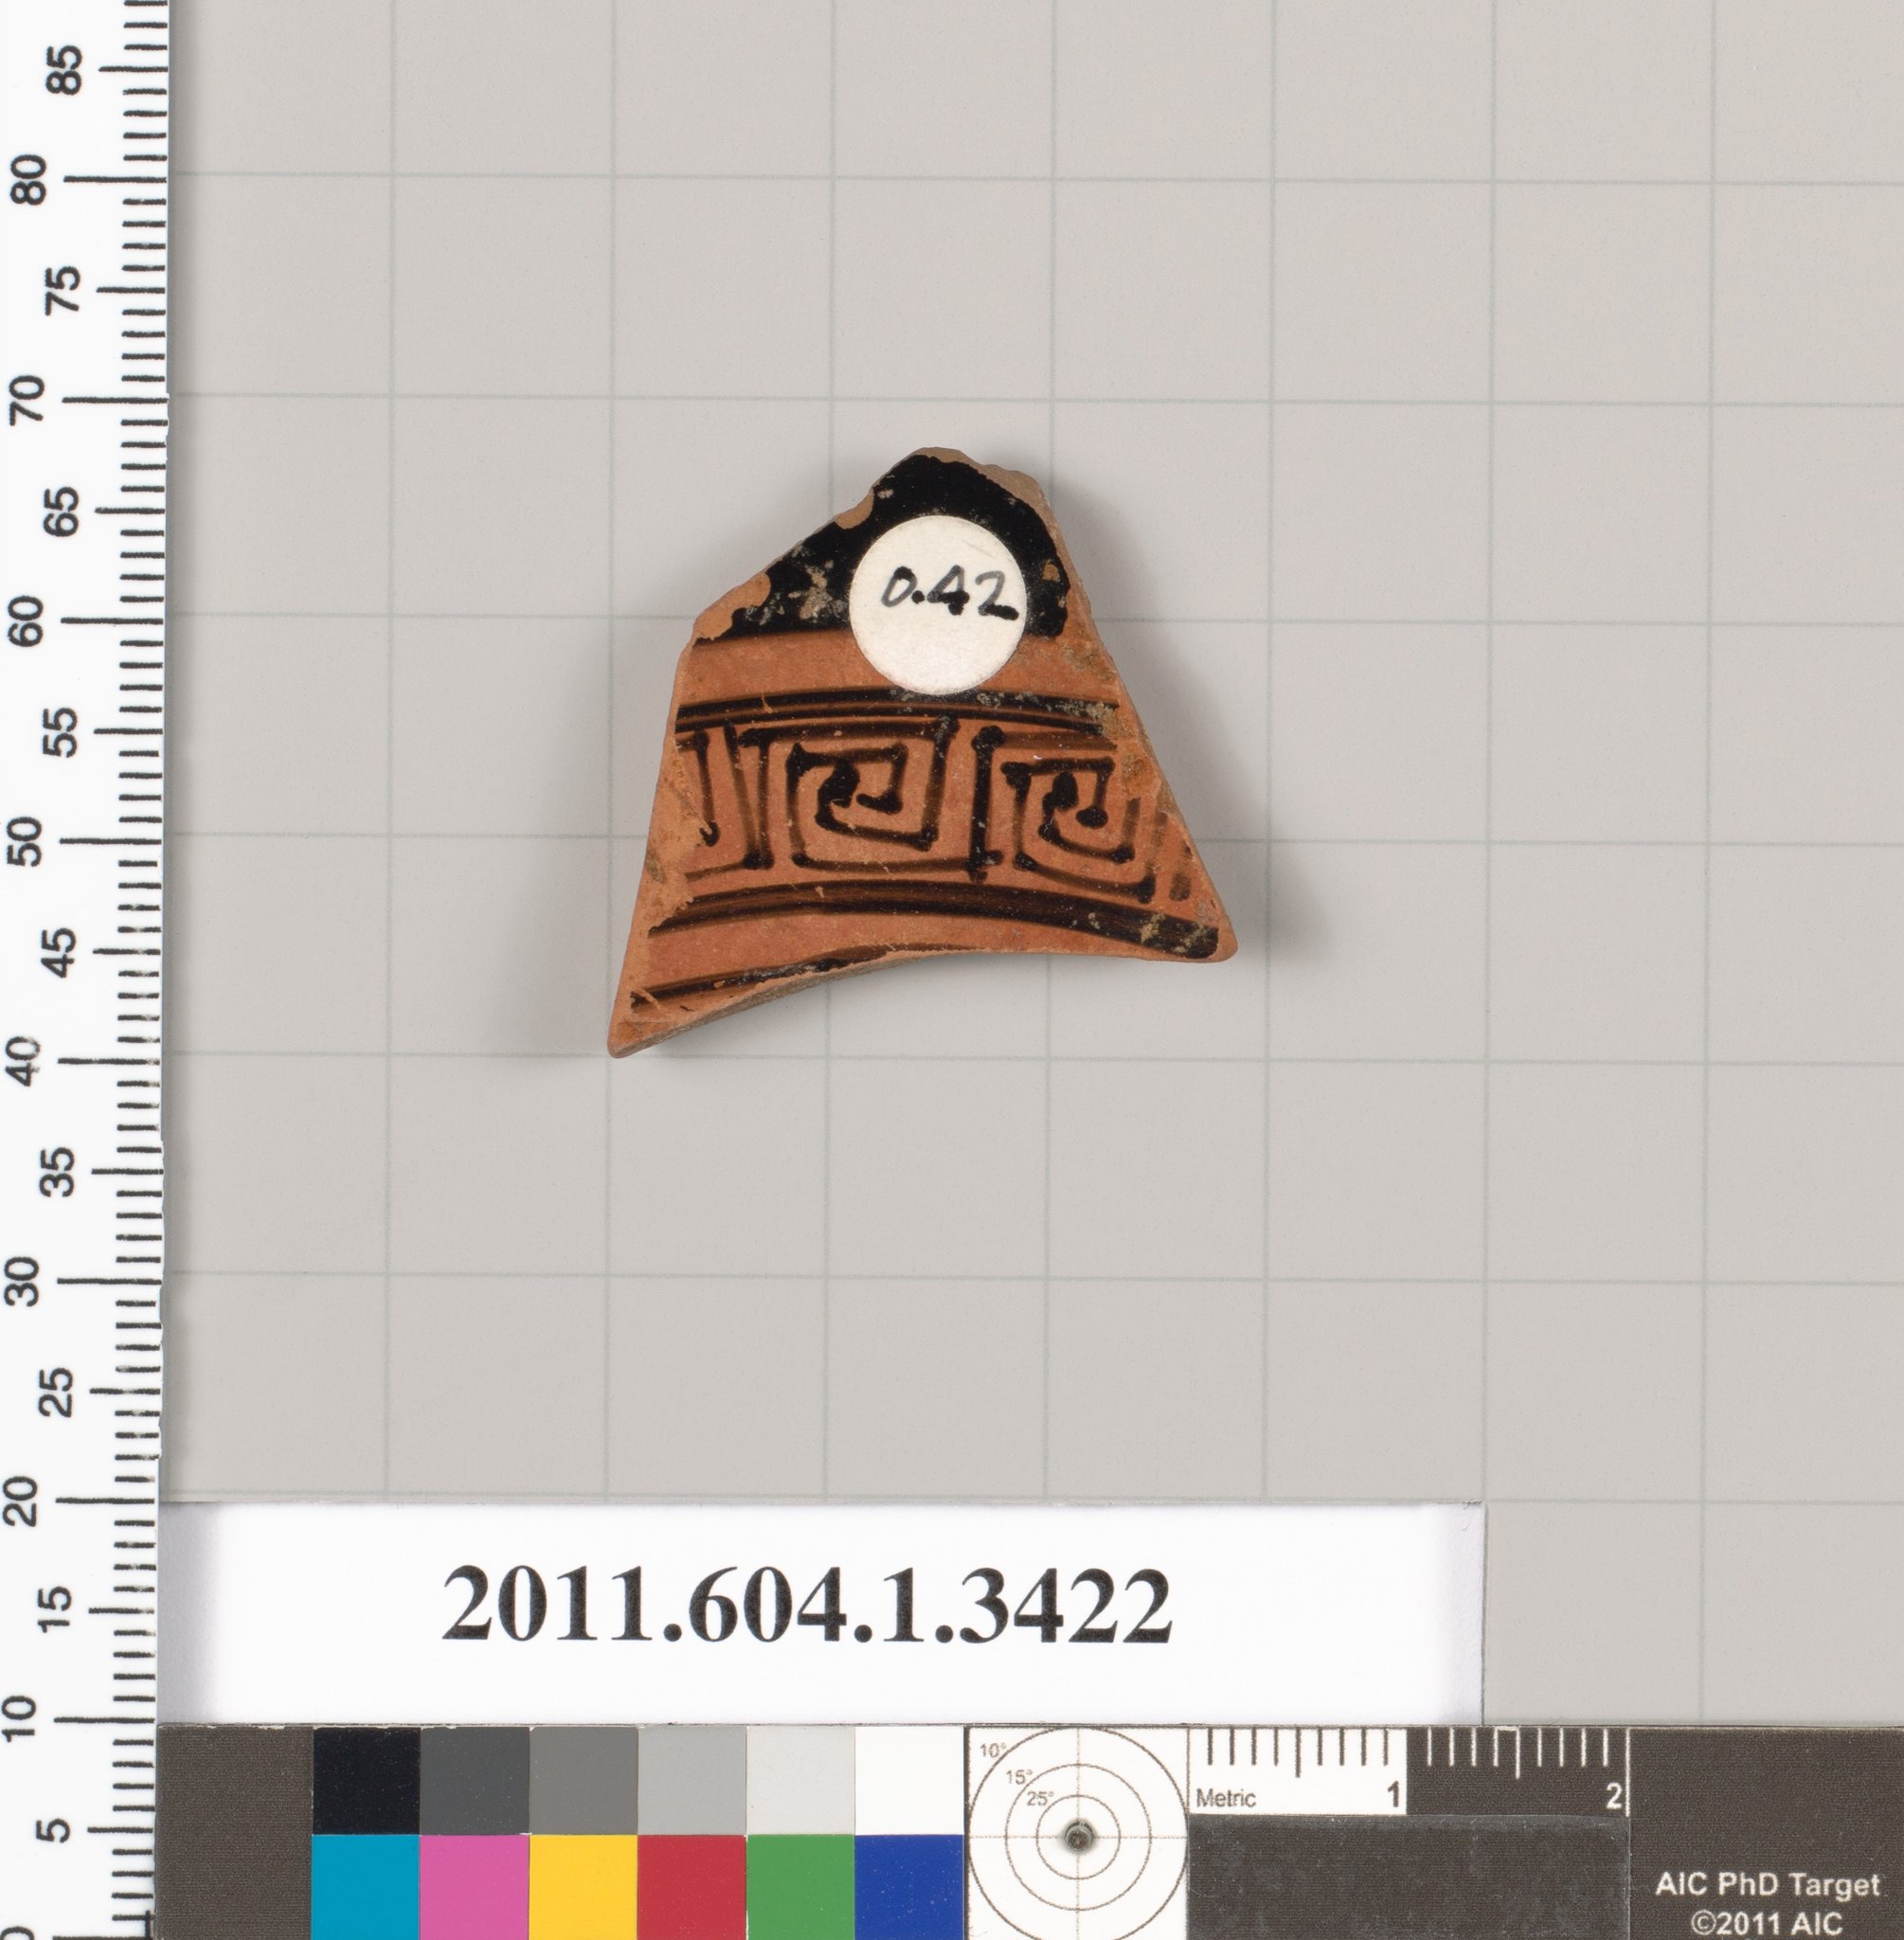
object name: kylix fragment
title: Terracotta fragment of a kylix (drinking cup)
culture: greek, attic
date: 490-470 BCE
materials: terracotta